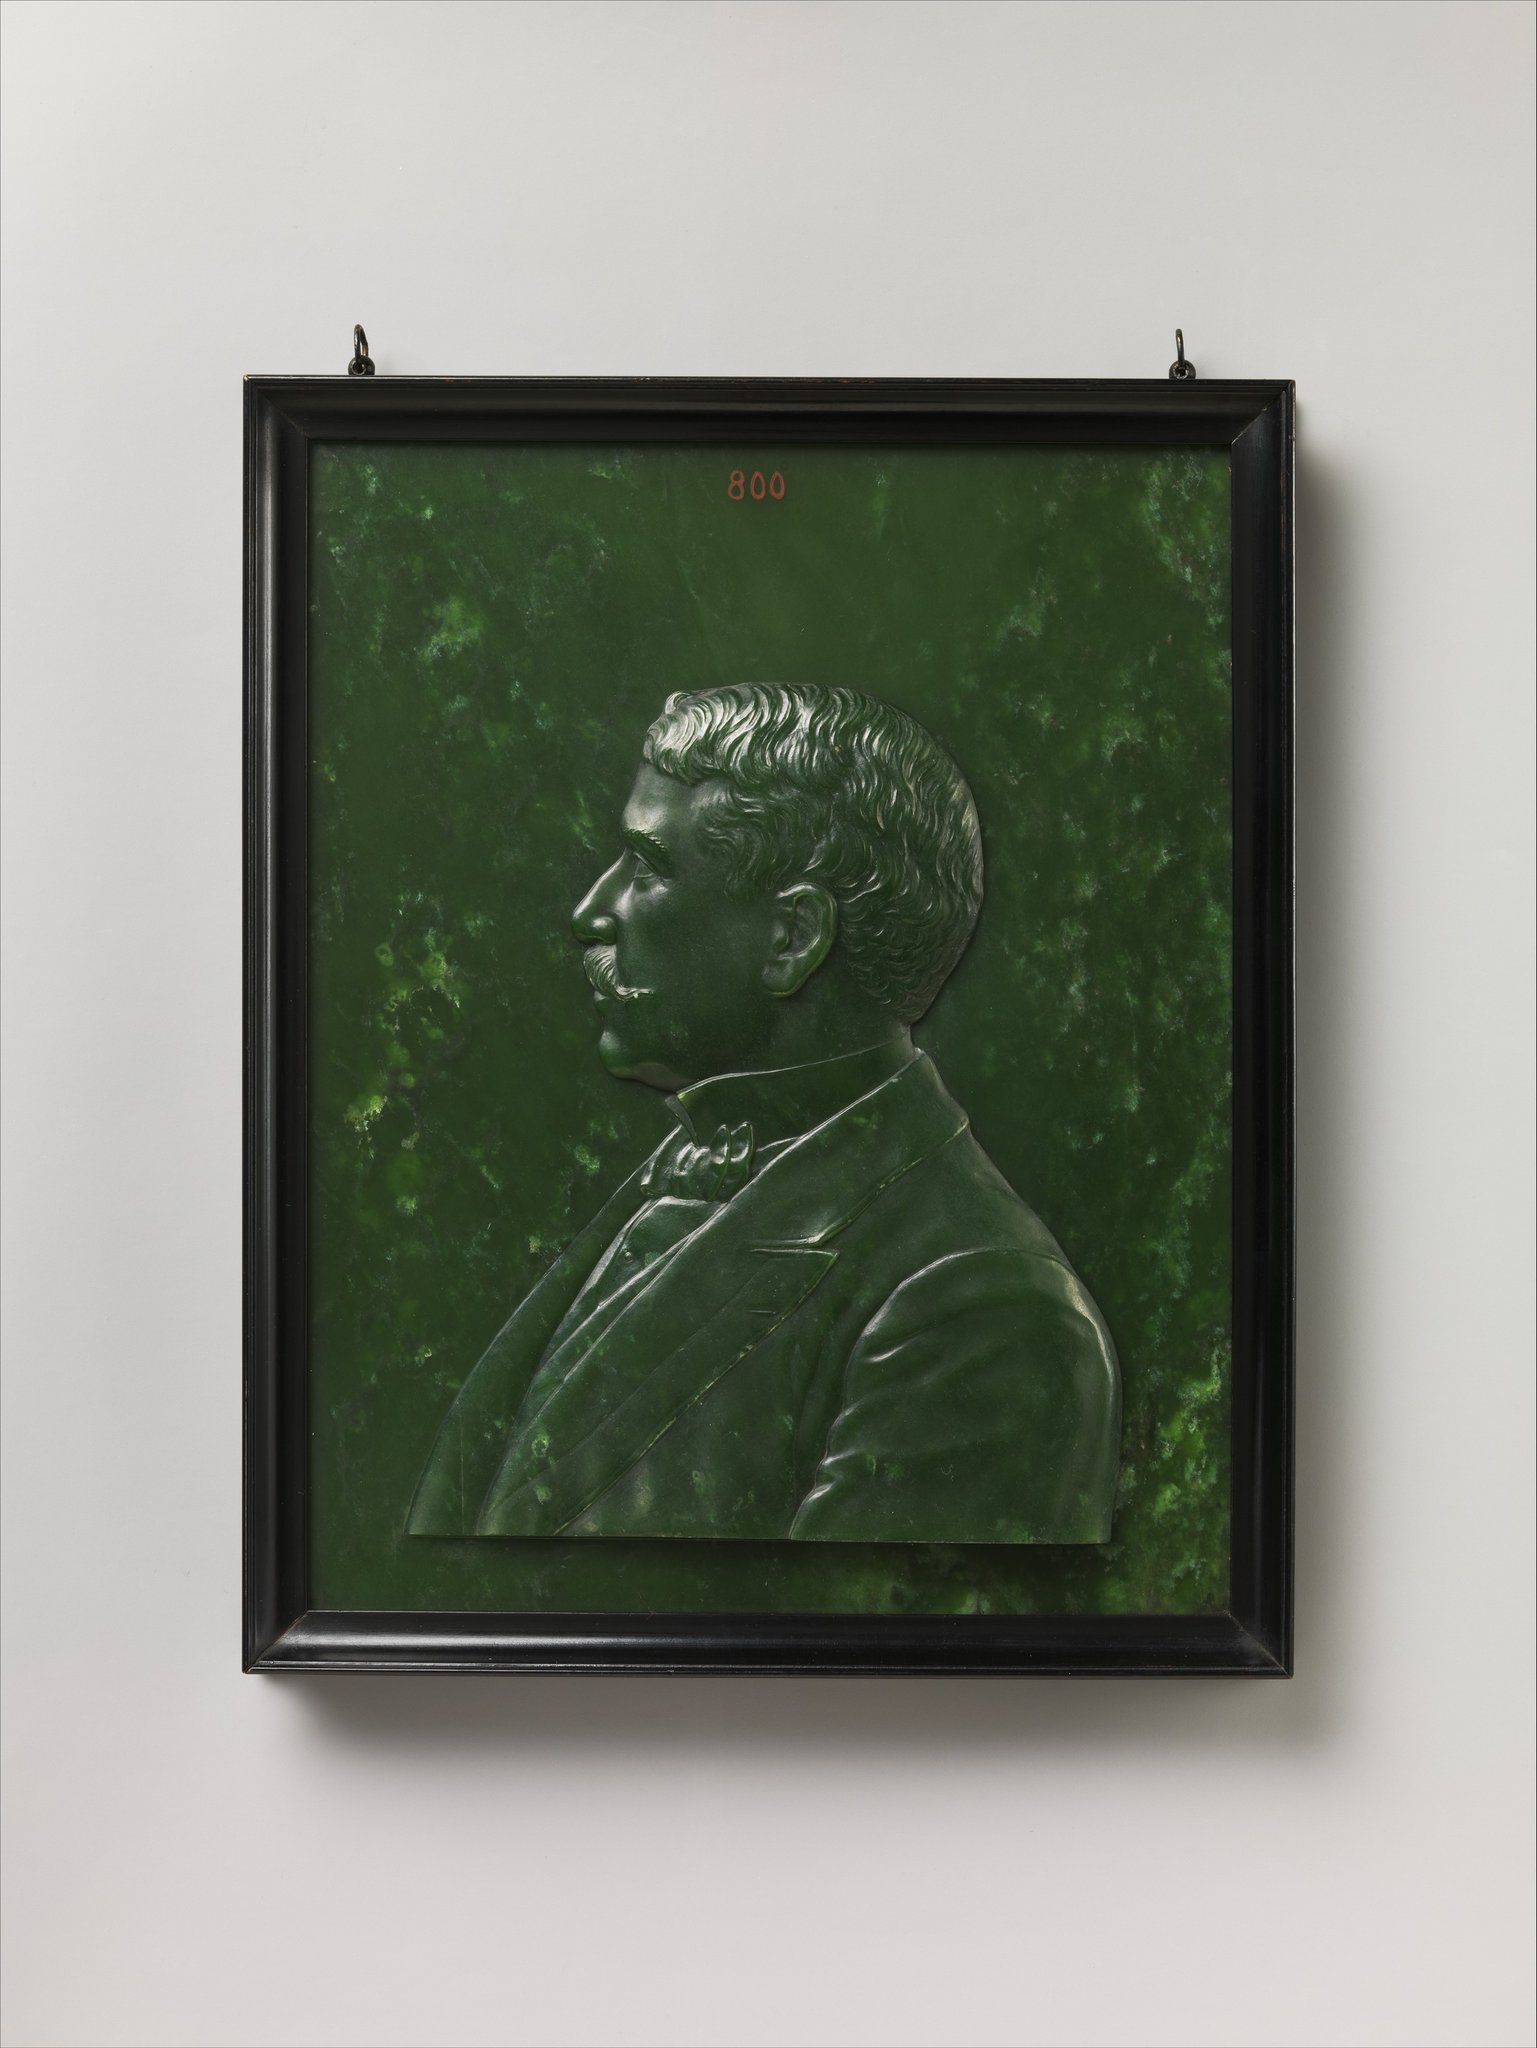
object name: relief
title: Portrait of Heber R. Bishop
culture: french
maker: berquin-varangoz workshop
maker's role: artist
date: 1898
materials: jade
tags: men,profiles